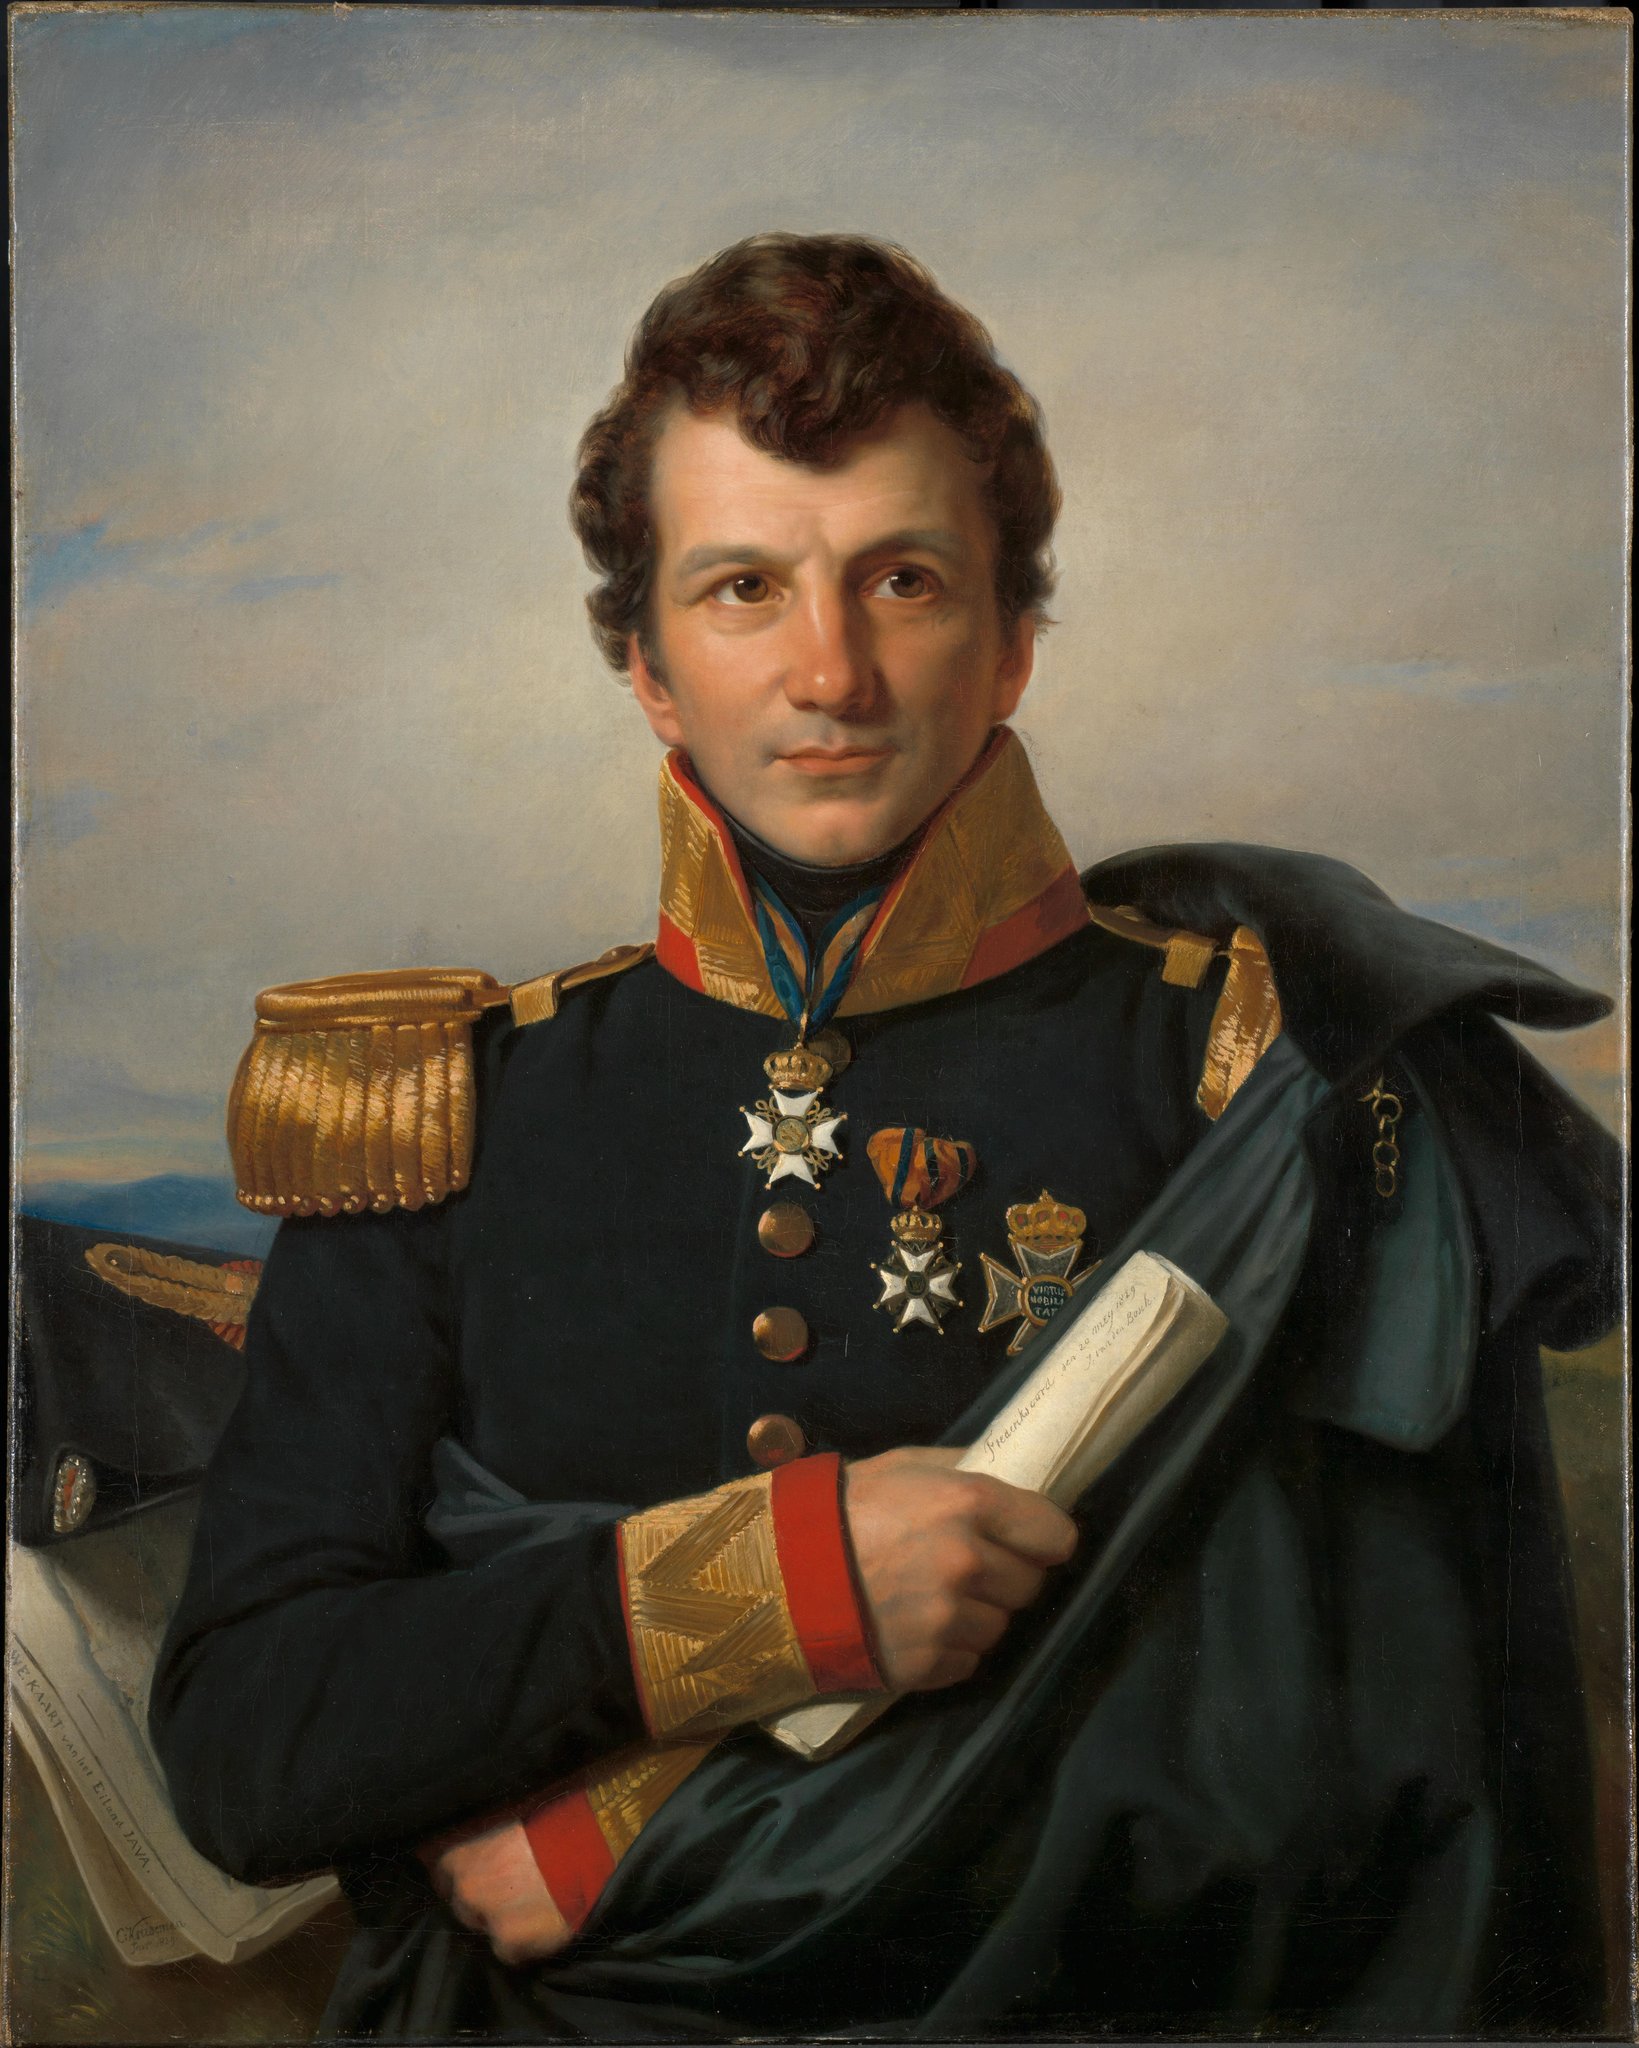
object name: painting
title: Count Johannes van den Bosch (1780-1844), Governor-general of the Dutch East Indies, Colonial Minister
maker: cornelis kruseman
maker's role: draughtsman, painter, print maker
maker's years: 1797-1857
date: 1829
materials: canvas, oil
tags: the hague, johannes graaf van den bosch, colonial governor, historical persons, dutch east indies, the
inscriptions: signature and date: ‘C. Kruseman Fecit 1829’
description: Kruseman portrayed Johannes van den Bosch just before his departure to the Dutch East Indies. In his right hand he holds a map of his destination, Java. He instituted a ‘Culture System’ there in 1830. Farmers were coerced into devoting part of their land to export crops, such as coffee and sugar, for the Dutch government. While this income may have benefitted the Netherlands’ treasury, the Indonesian population suffered from corruption, poverty, and famine.